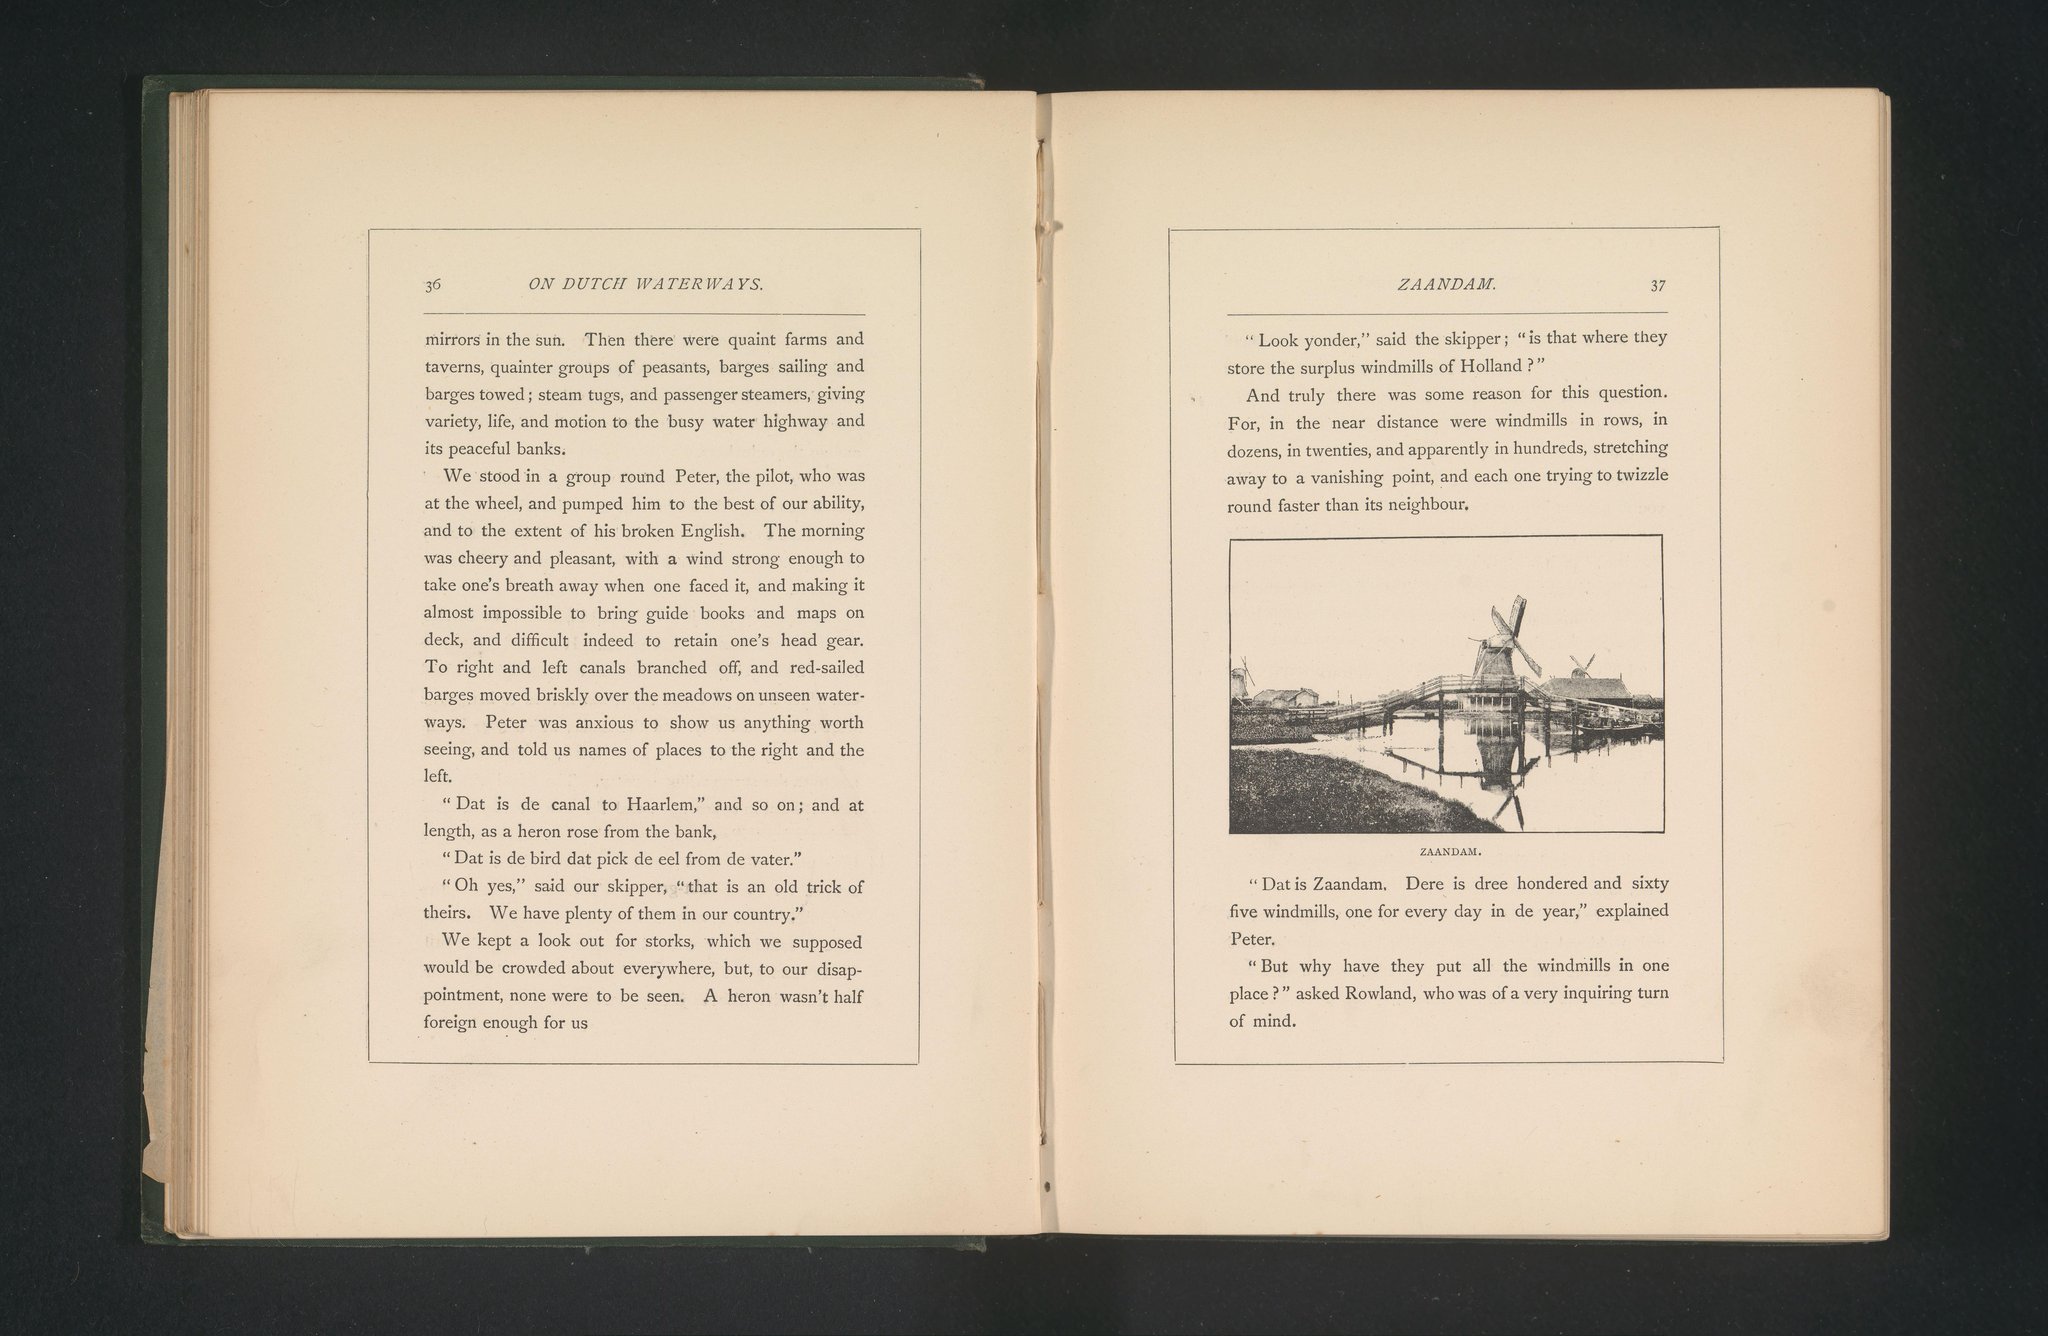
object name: page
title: Zaandam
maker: george christopher davies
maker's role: fotograaf, geoloog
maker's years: 1849-1922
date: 1881-1886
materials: paper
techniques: autotype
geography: london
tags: bridge, windmill